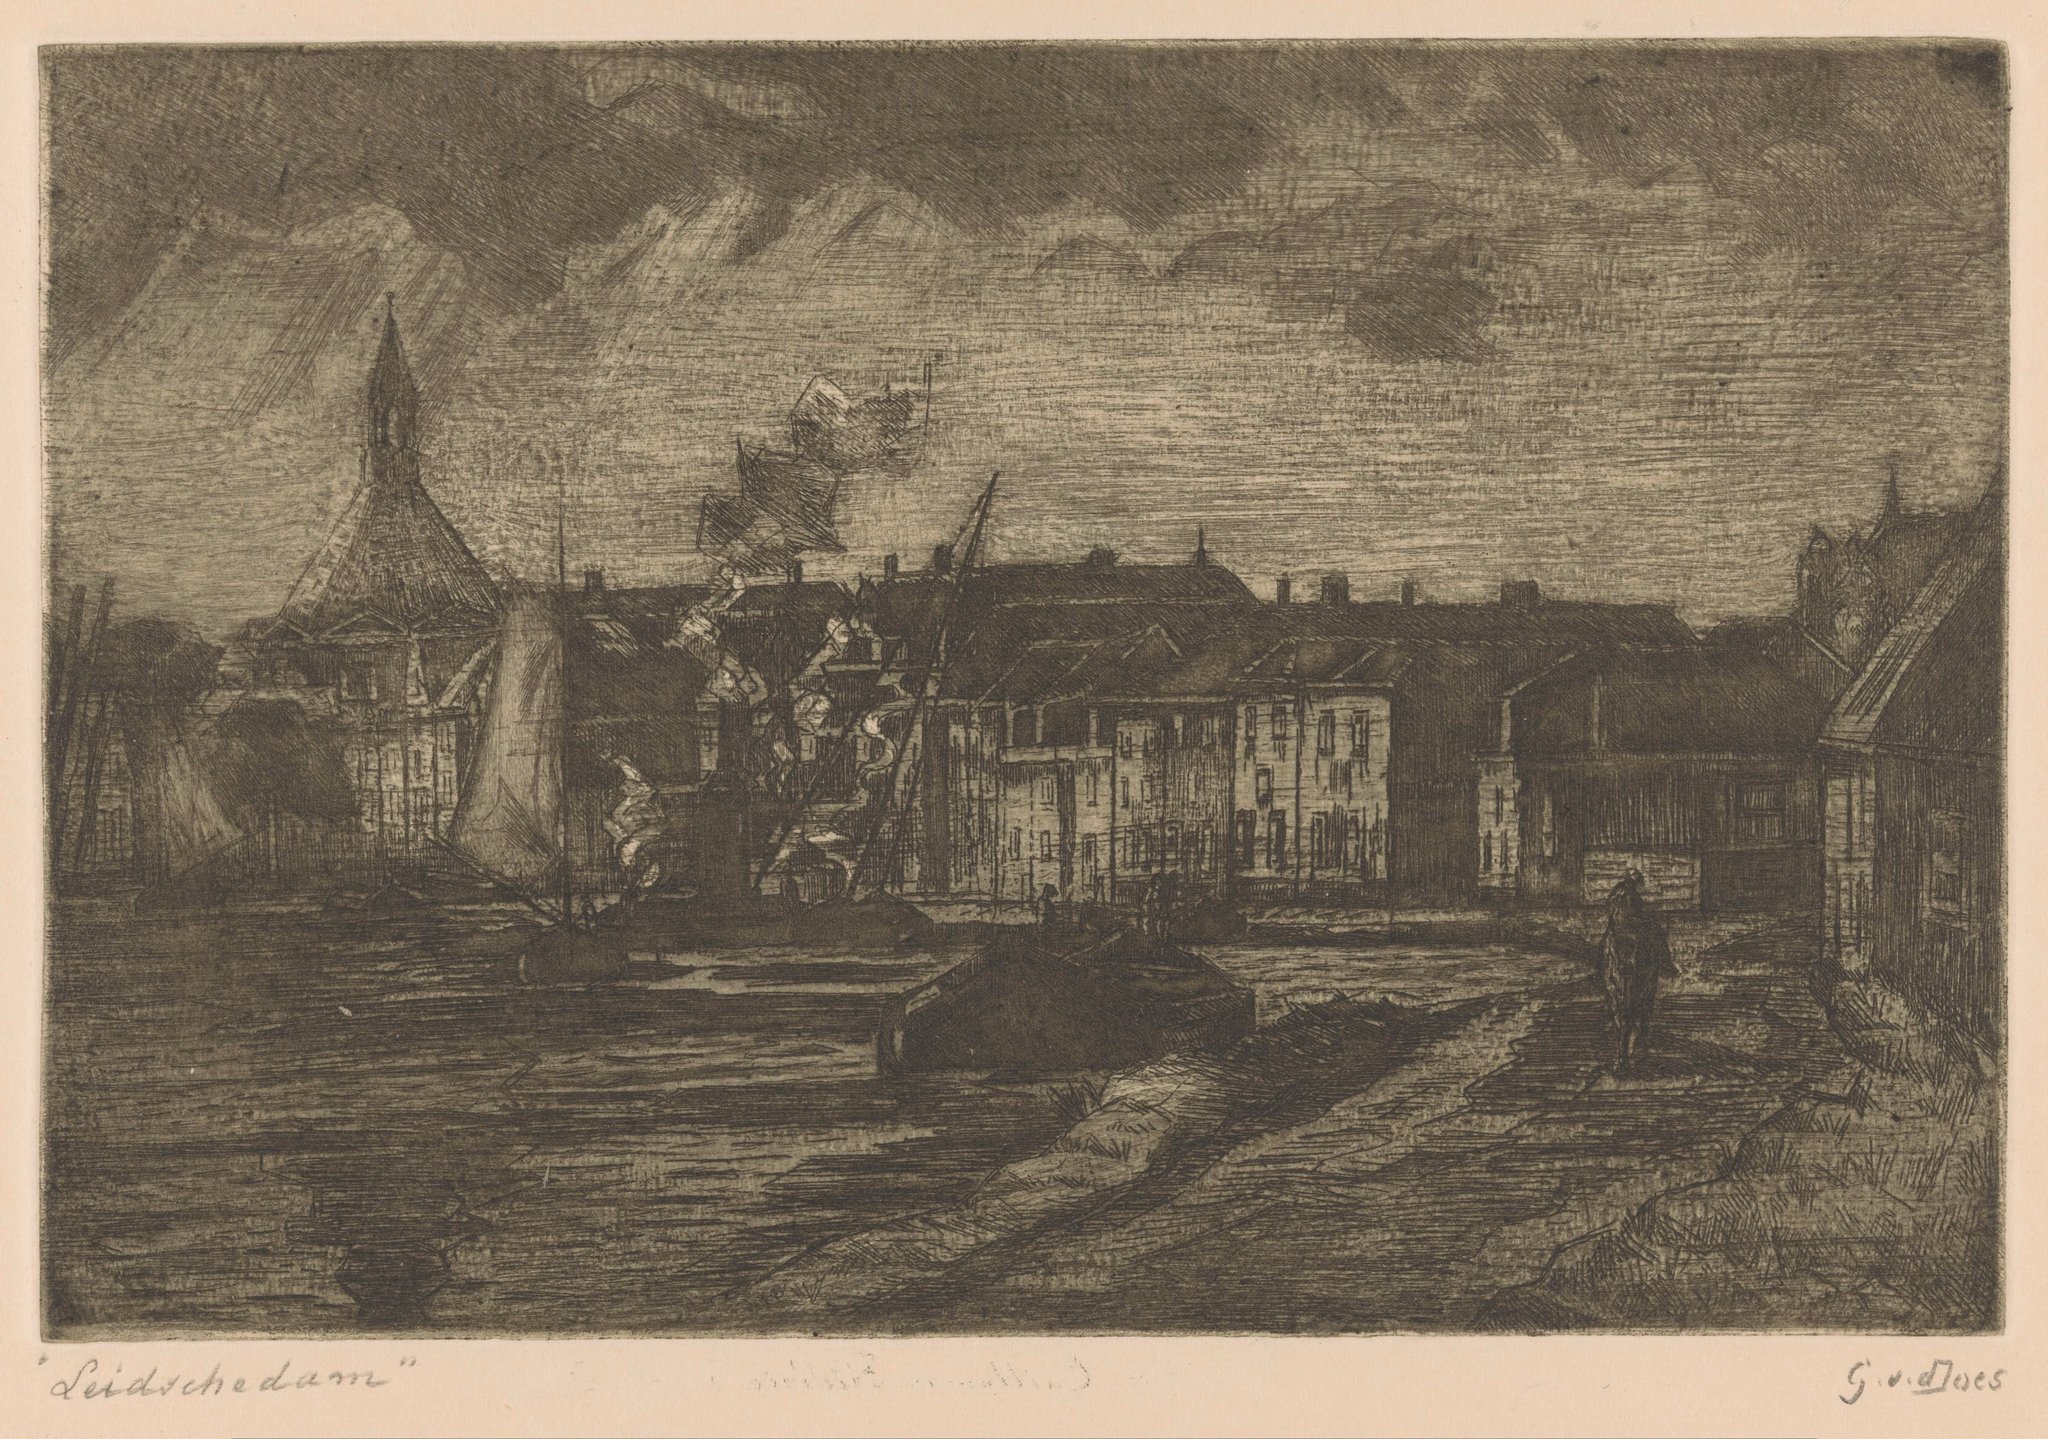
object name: print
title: Leidschendam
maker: gustave van der does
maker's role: print maker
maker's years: 1878-1922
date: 1888-1922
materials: paper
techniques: etching, intaglio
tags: canals, waters (in city)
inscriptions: collector's mark: Lugt 2228, collector's mark: Lugt 2760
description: Een gezicht op Leidschendam met onder meer de Dorpskerk aan de Delftsekade langs de Vliet.